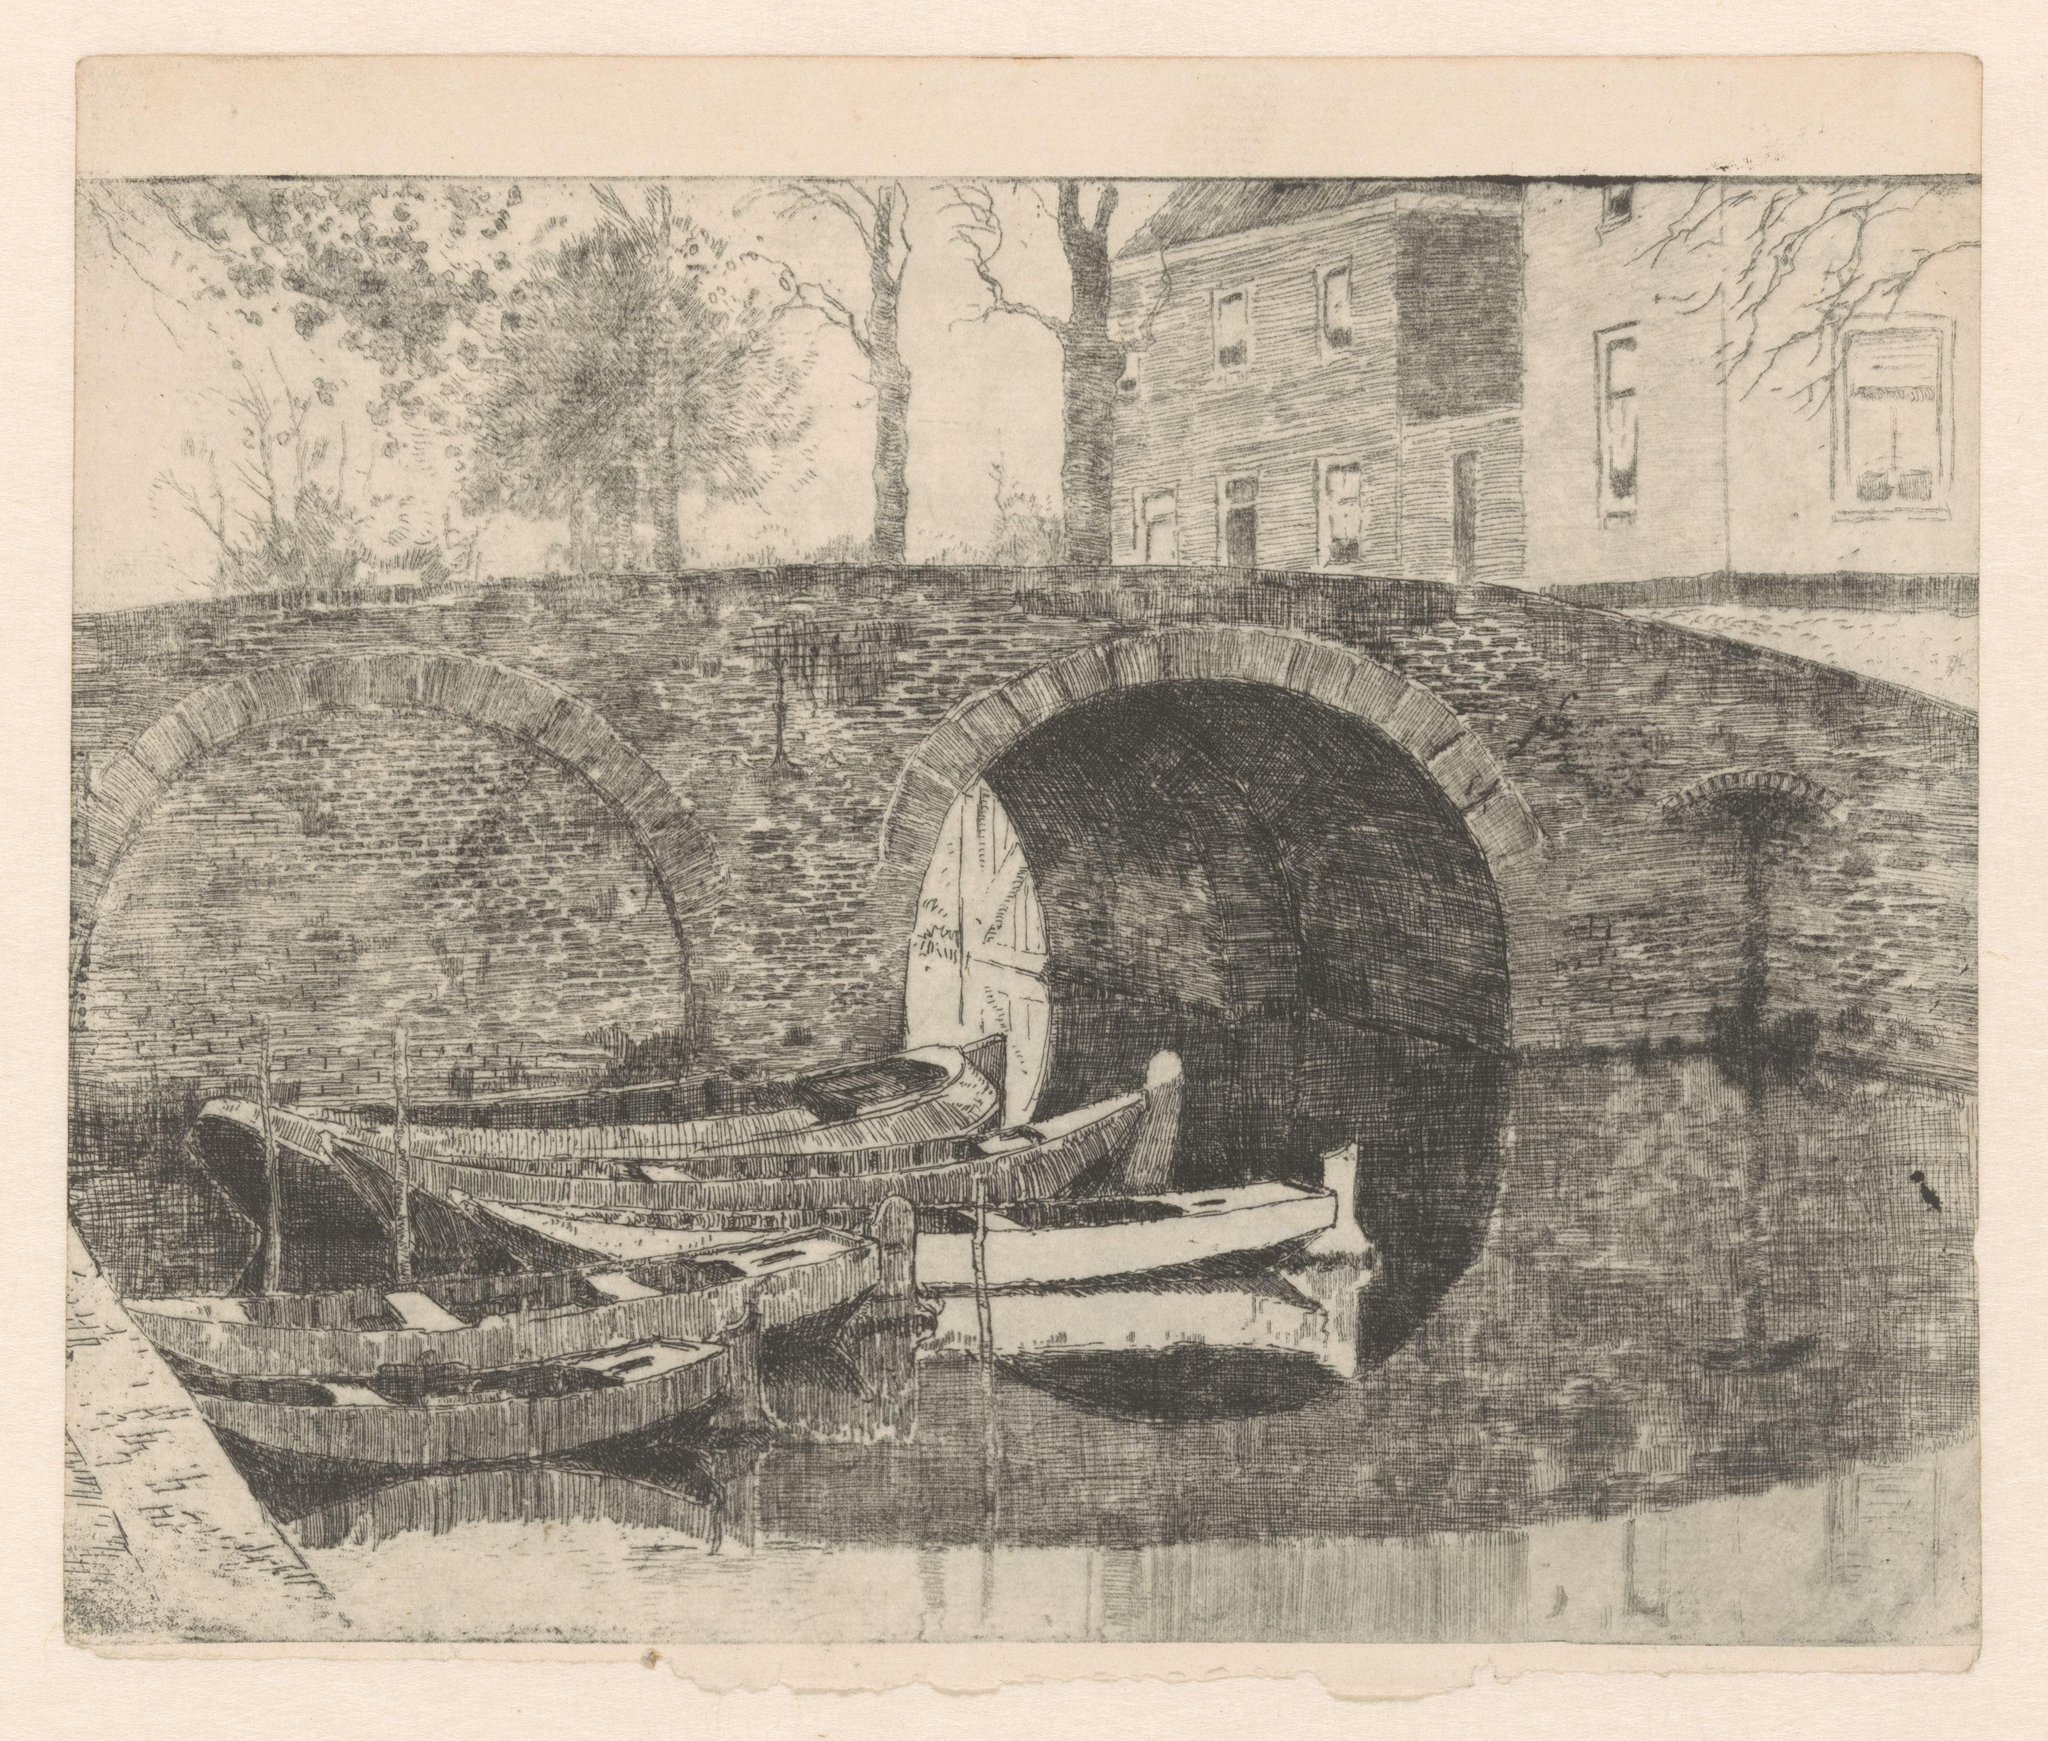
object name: print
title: Brug over een gracht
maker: cornelis vreedenburgh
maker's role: draughtsman, print maker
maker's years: 1880-1946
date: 1914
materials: paper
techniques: drypoint, etching, intaglio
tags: rowing-boat, canoe, etc., bridge in city across river, canal, etc.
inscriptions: collector's mark: Lugt 2760, collector's mark: Lugt 2228